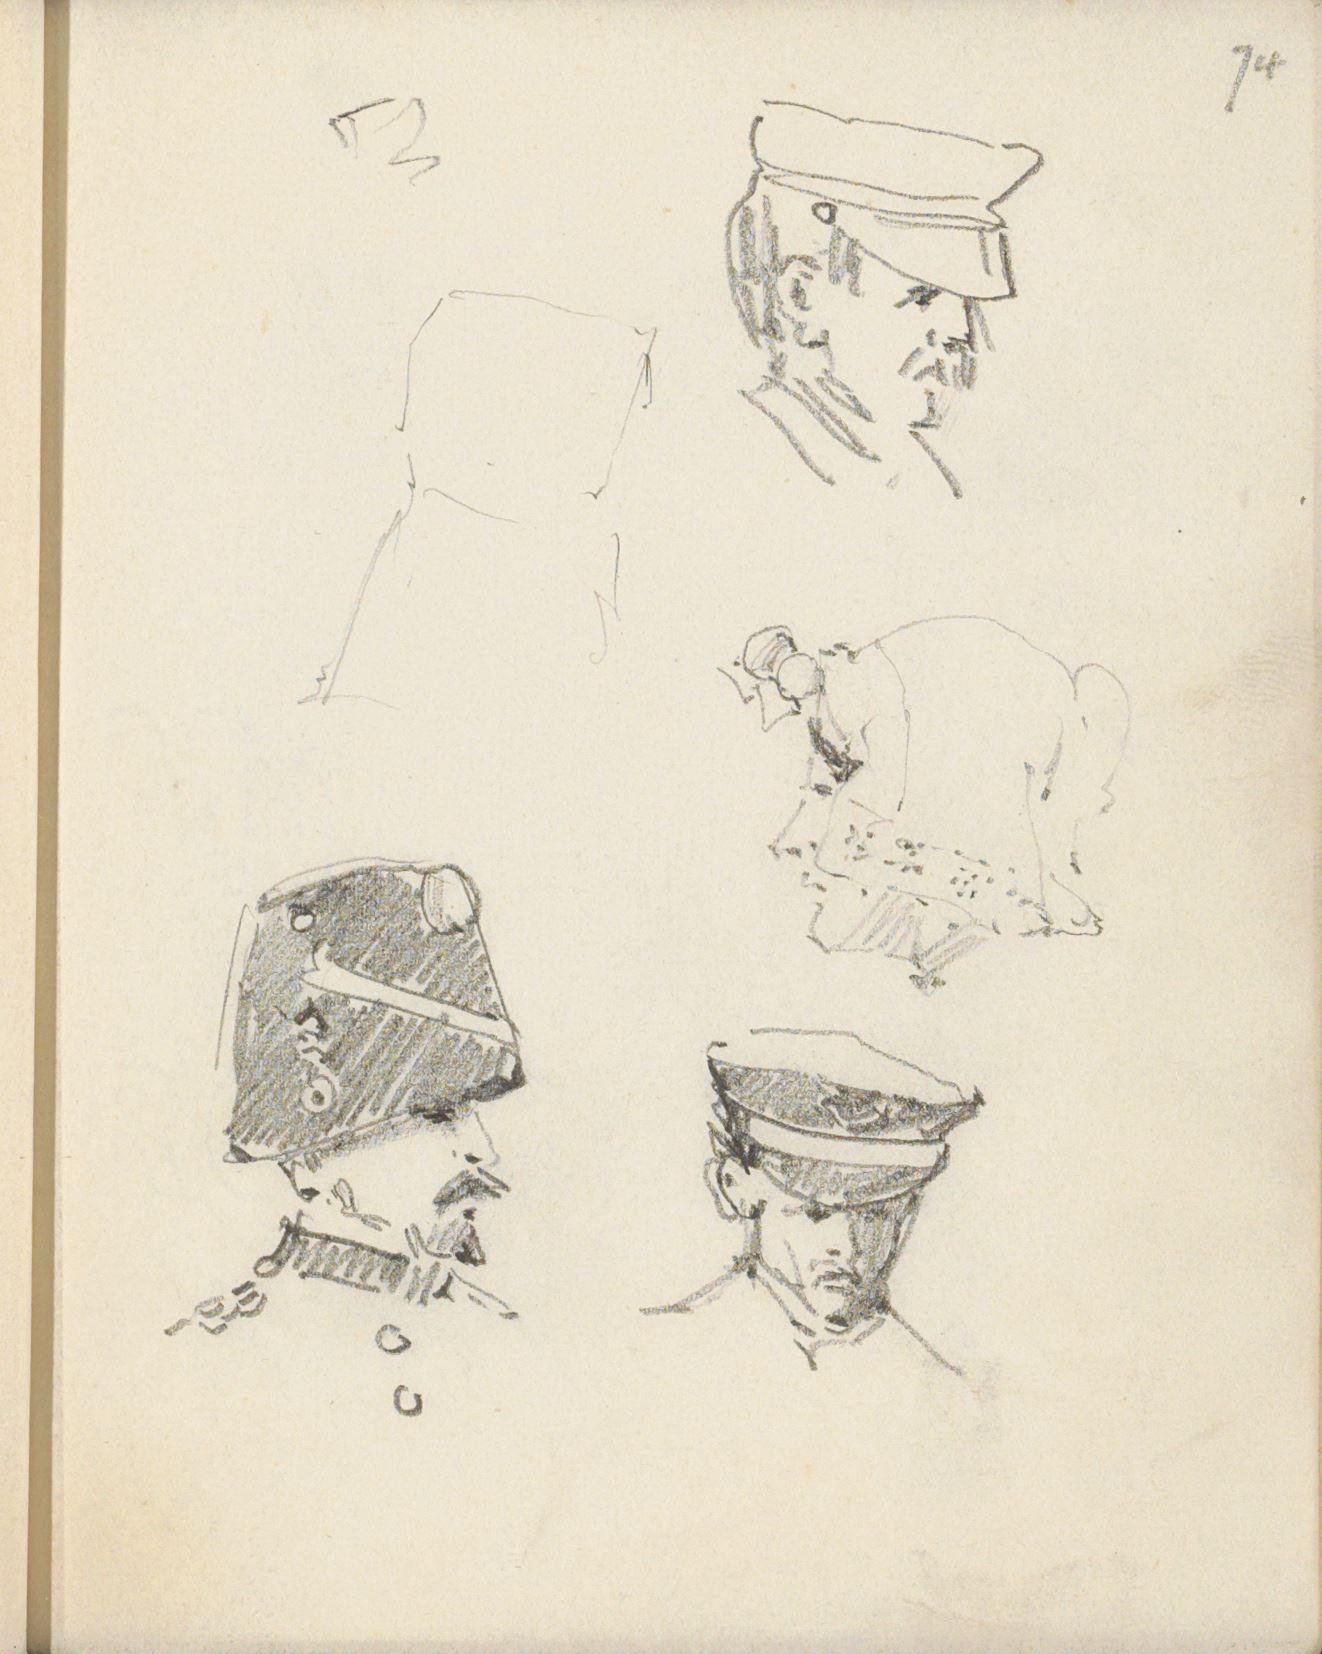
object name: sketchbook leaf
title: Mannen en een vrouw met verschillende hoofddeksels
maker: alfred william rich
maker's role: draughtsman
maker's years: 1856-1921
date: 1892-1893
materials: paper, pencil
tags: head-gear: hat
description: De vrouw draagt een kap, de mannen petten en een muts. Blad 74 recto uit een schetsboek met 86 bladen.